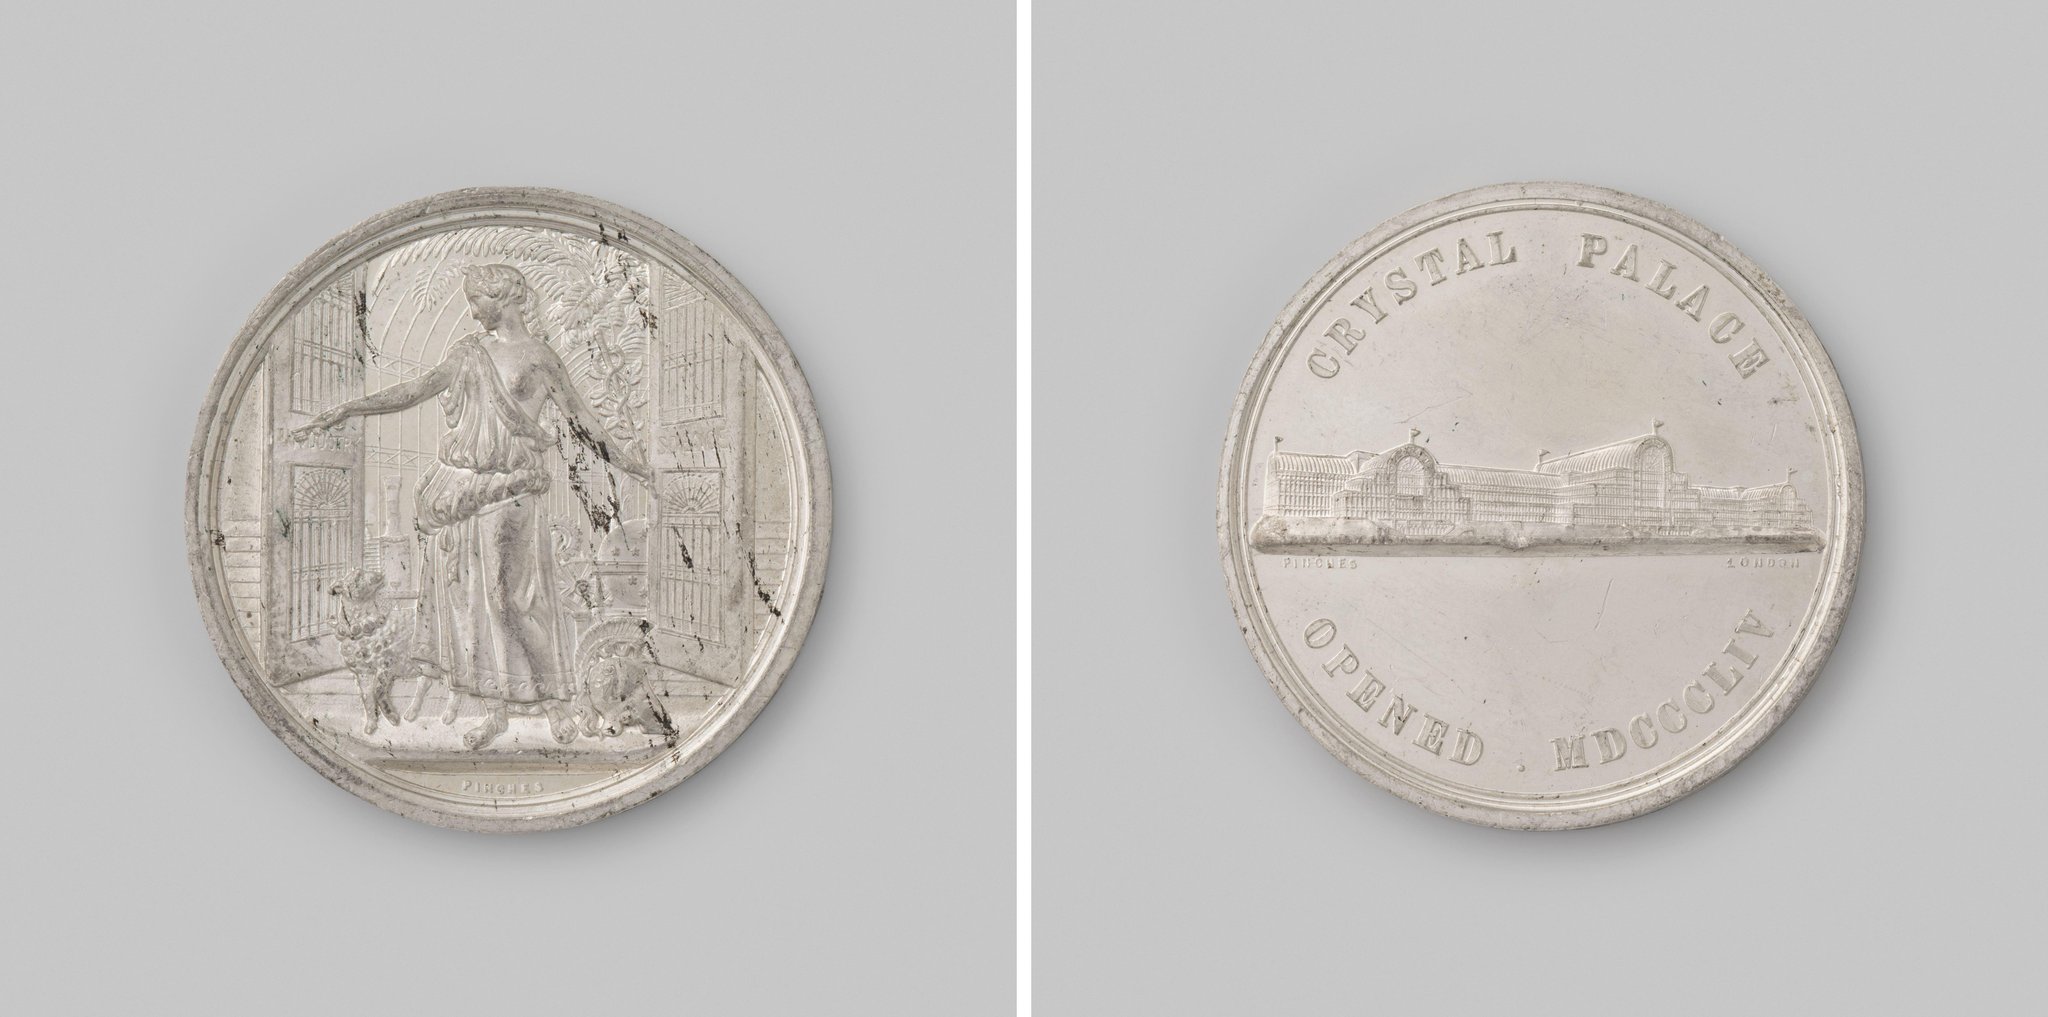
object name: history medal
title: Opening van Crystal Palace te Londen 1854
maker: john pinches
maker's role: medailleur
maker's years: 1846-1905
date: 1854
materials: tin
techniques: striking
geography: london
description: Tinnen penning, op de voorzijde een vrouw met palmtak en sleutel die deuren met opschrift INDUSTRIE en SCIENCE opent, te midden van symbolen van agricultuur, nijverheid en wetenschap, op de keerzijde het Crystal Palace met omschrift.